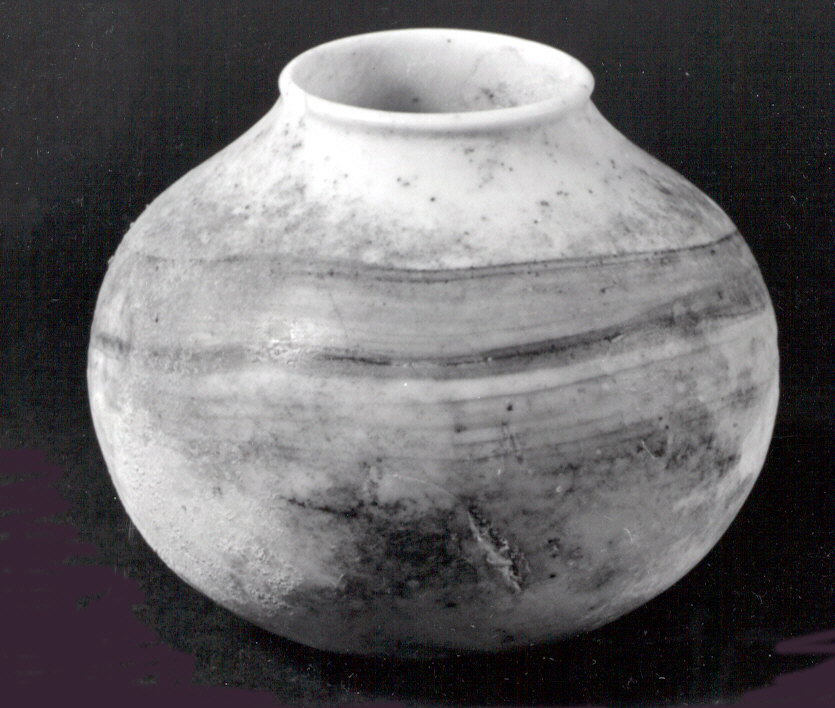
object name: jar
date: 7333-7001 BCE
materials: alabaster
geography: syria